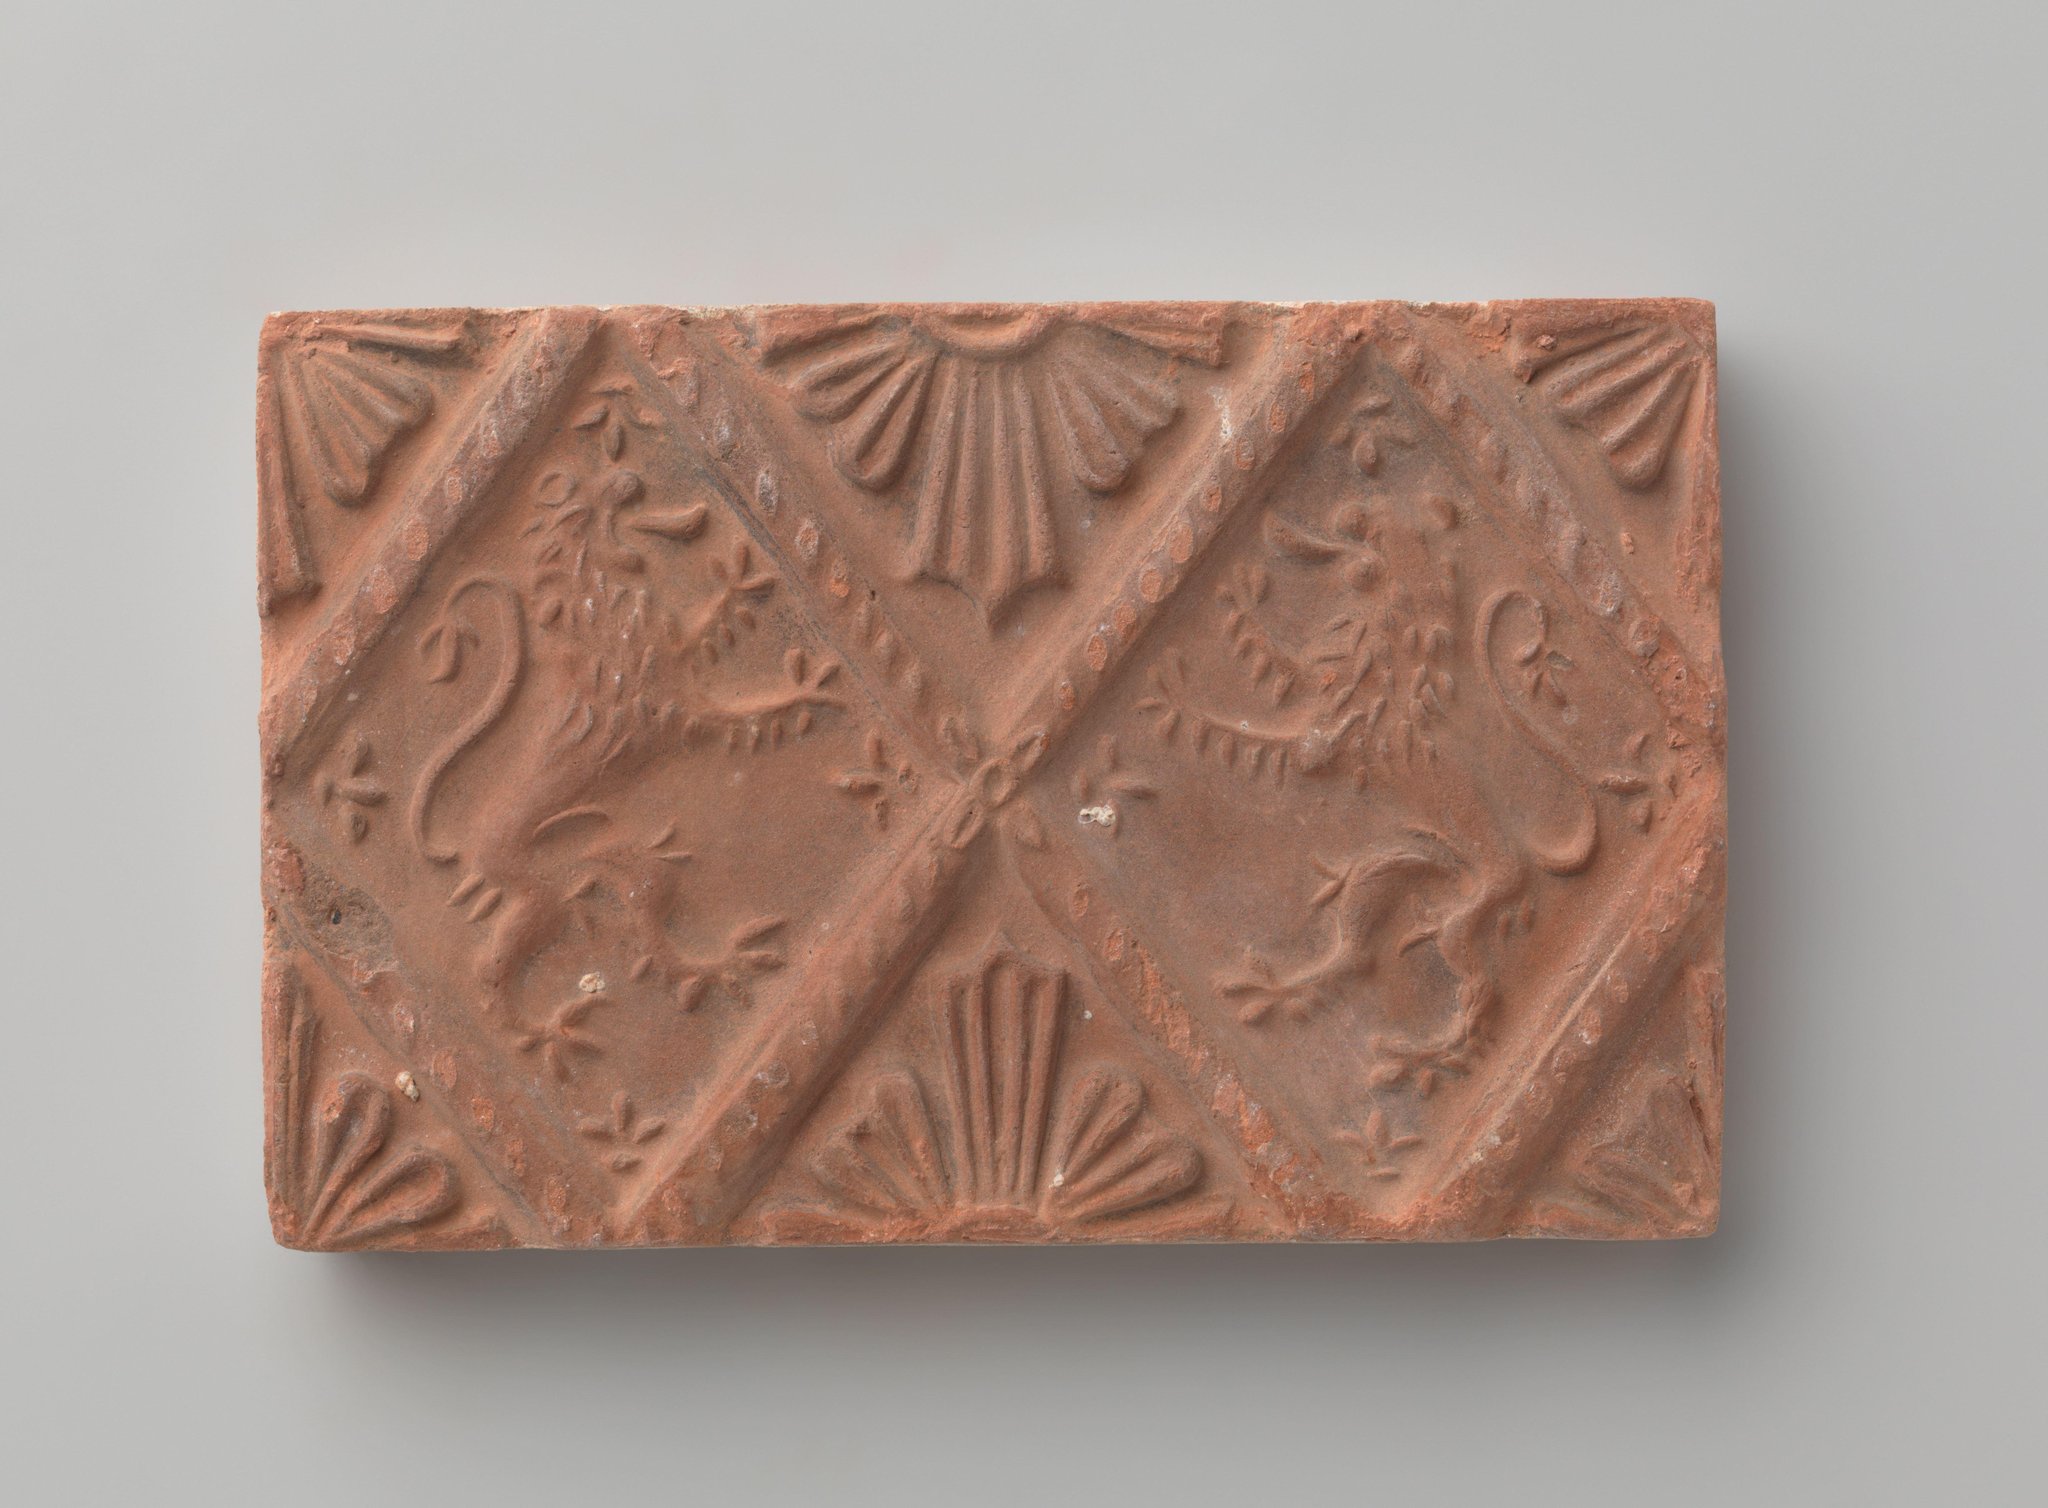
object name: hearthstone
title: Haardsteen met voorstelling van twee klimmende leeuwen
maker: Anonymous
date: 1875-1900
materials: earthenware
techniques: printing, firing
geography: netherlands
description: Haardsteen met voorstelling van twee klimmende leeuwen, geplaatst in geprofileerde ruit. De halve ruiten aan de boven- en onderkant zijn opgevuld met stermotief.